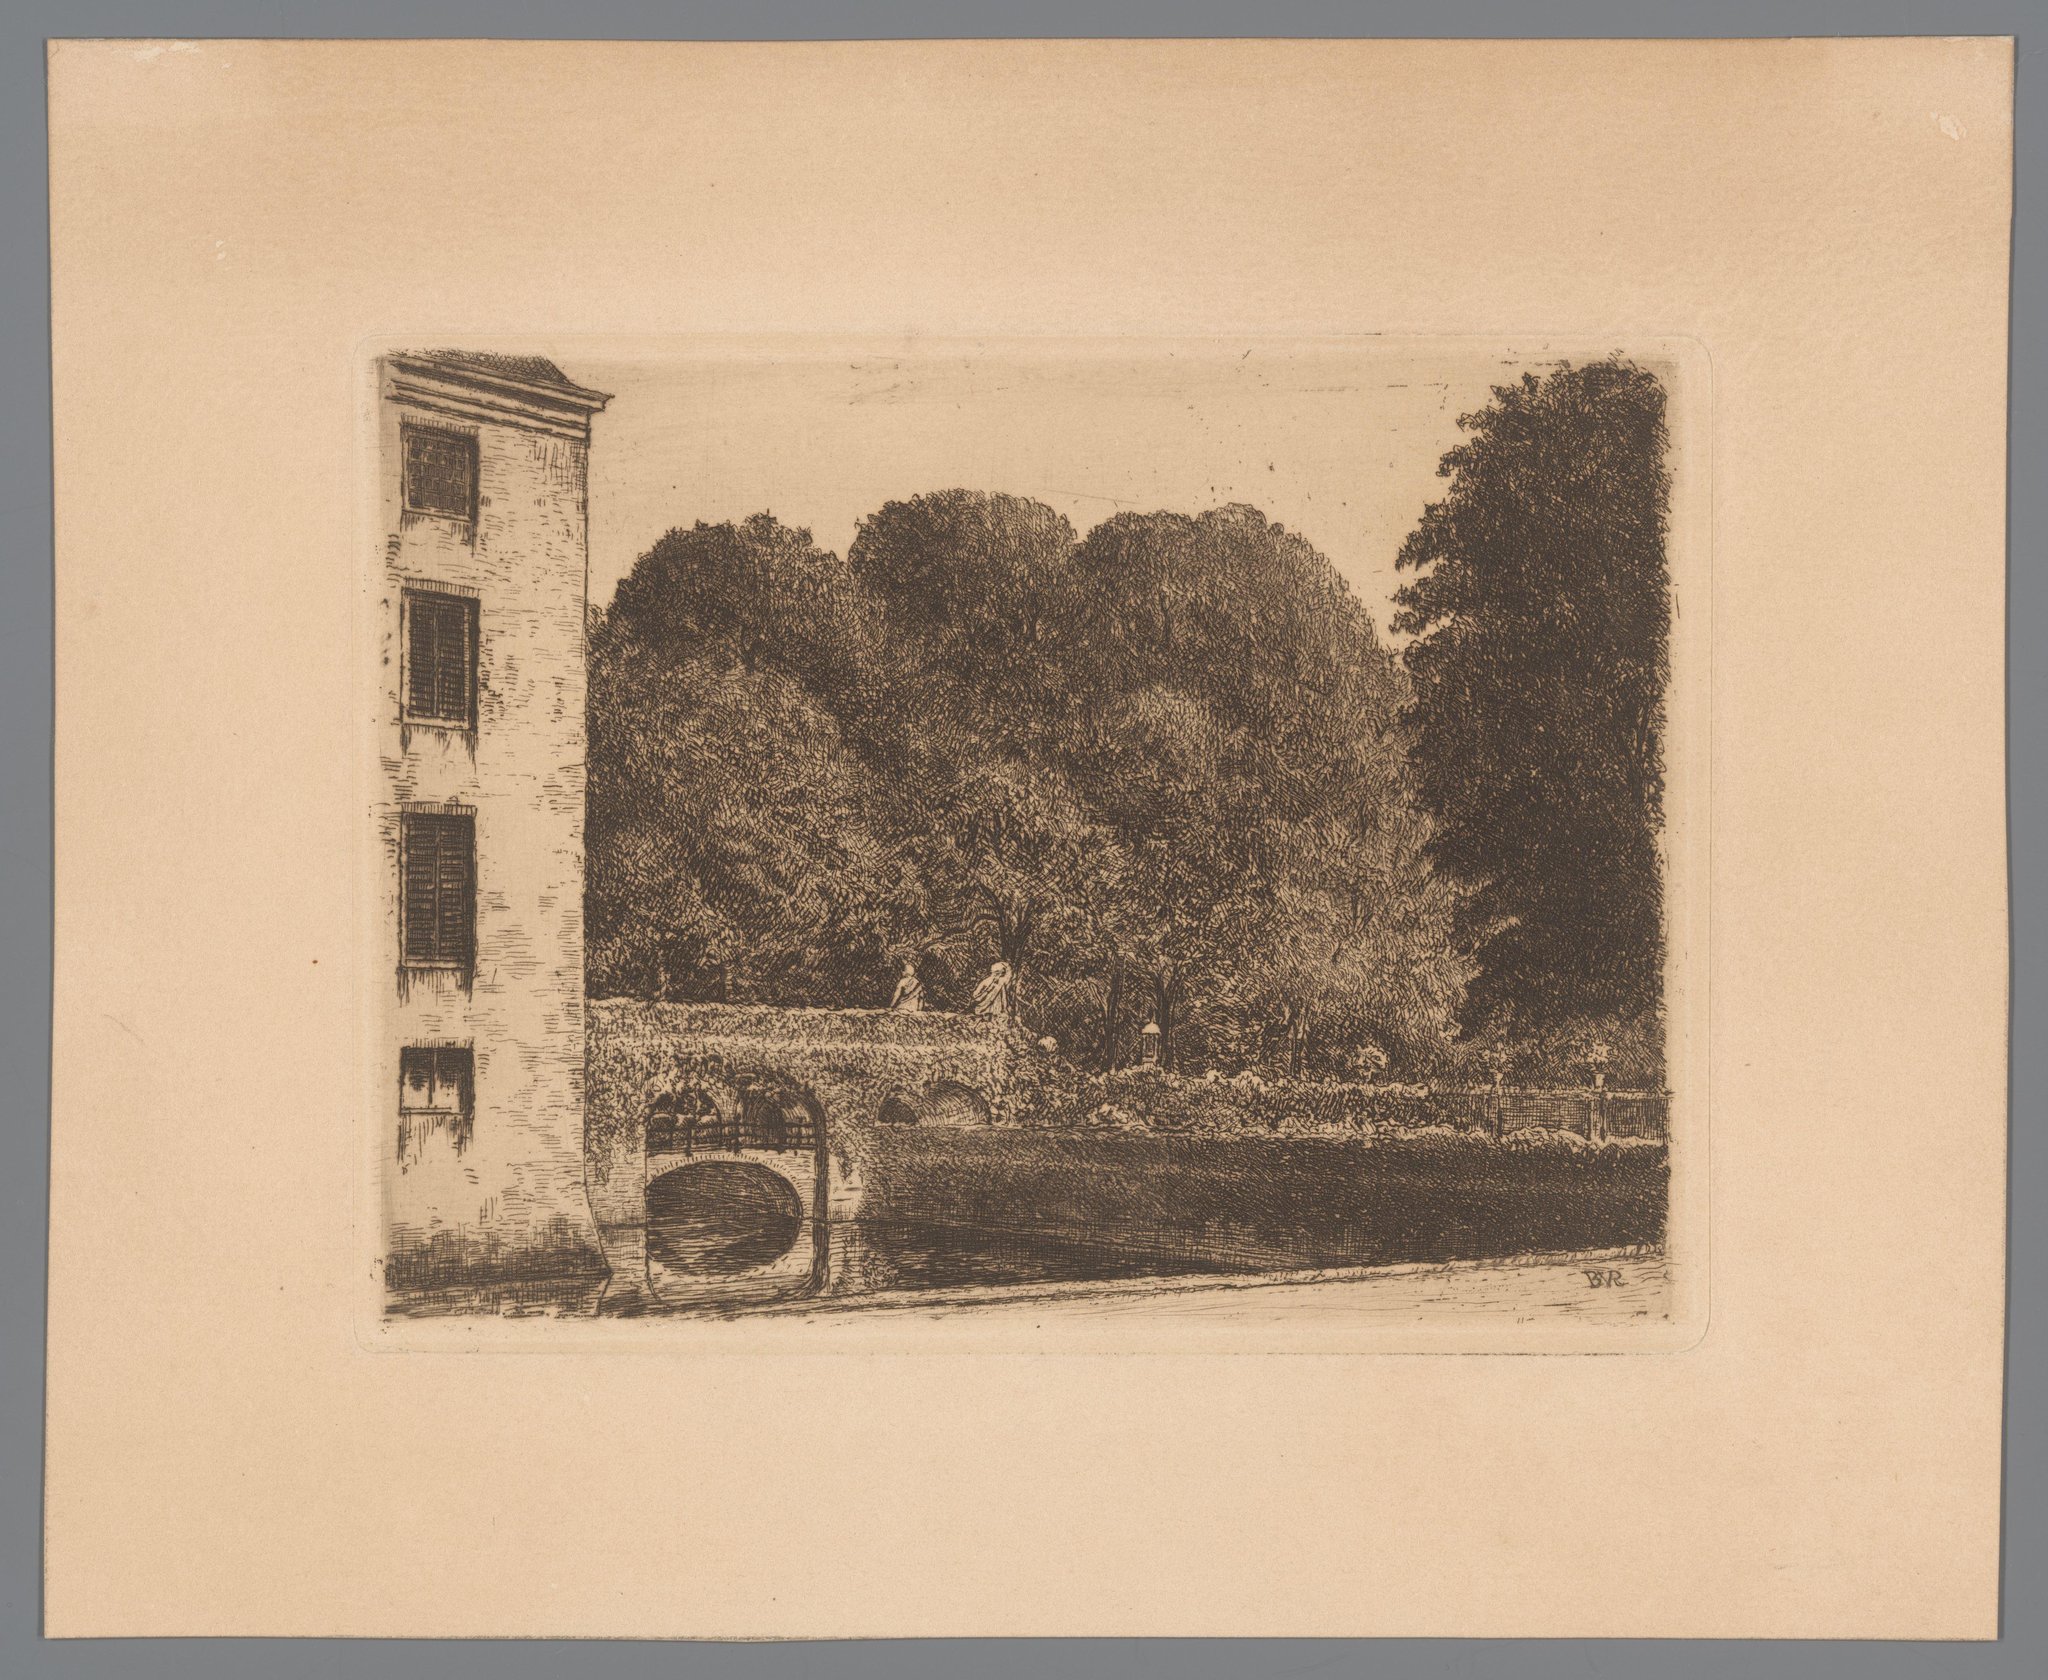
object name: print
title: Gezicht op kasteel Amerongen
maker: jonkheer barthold willem floris van riemsdijk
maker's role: engineer, print maker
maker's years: 1850-1942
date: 1917-1918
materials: paper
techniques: drypoint, etching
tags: castle, amerongen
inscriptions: collector's mark: Lugt 2228